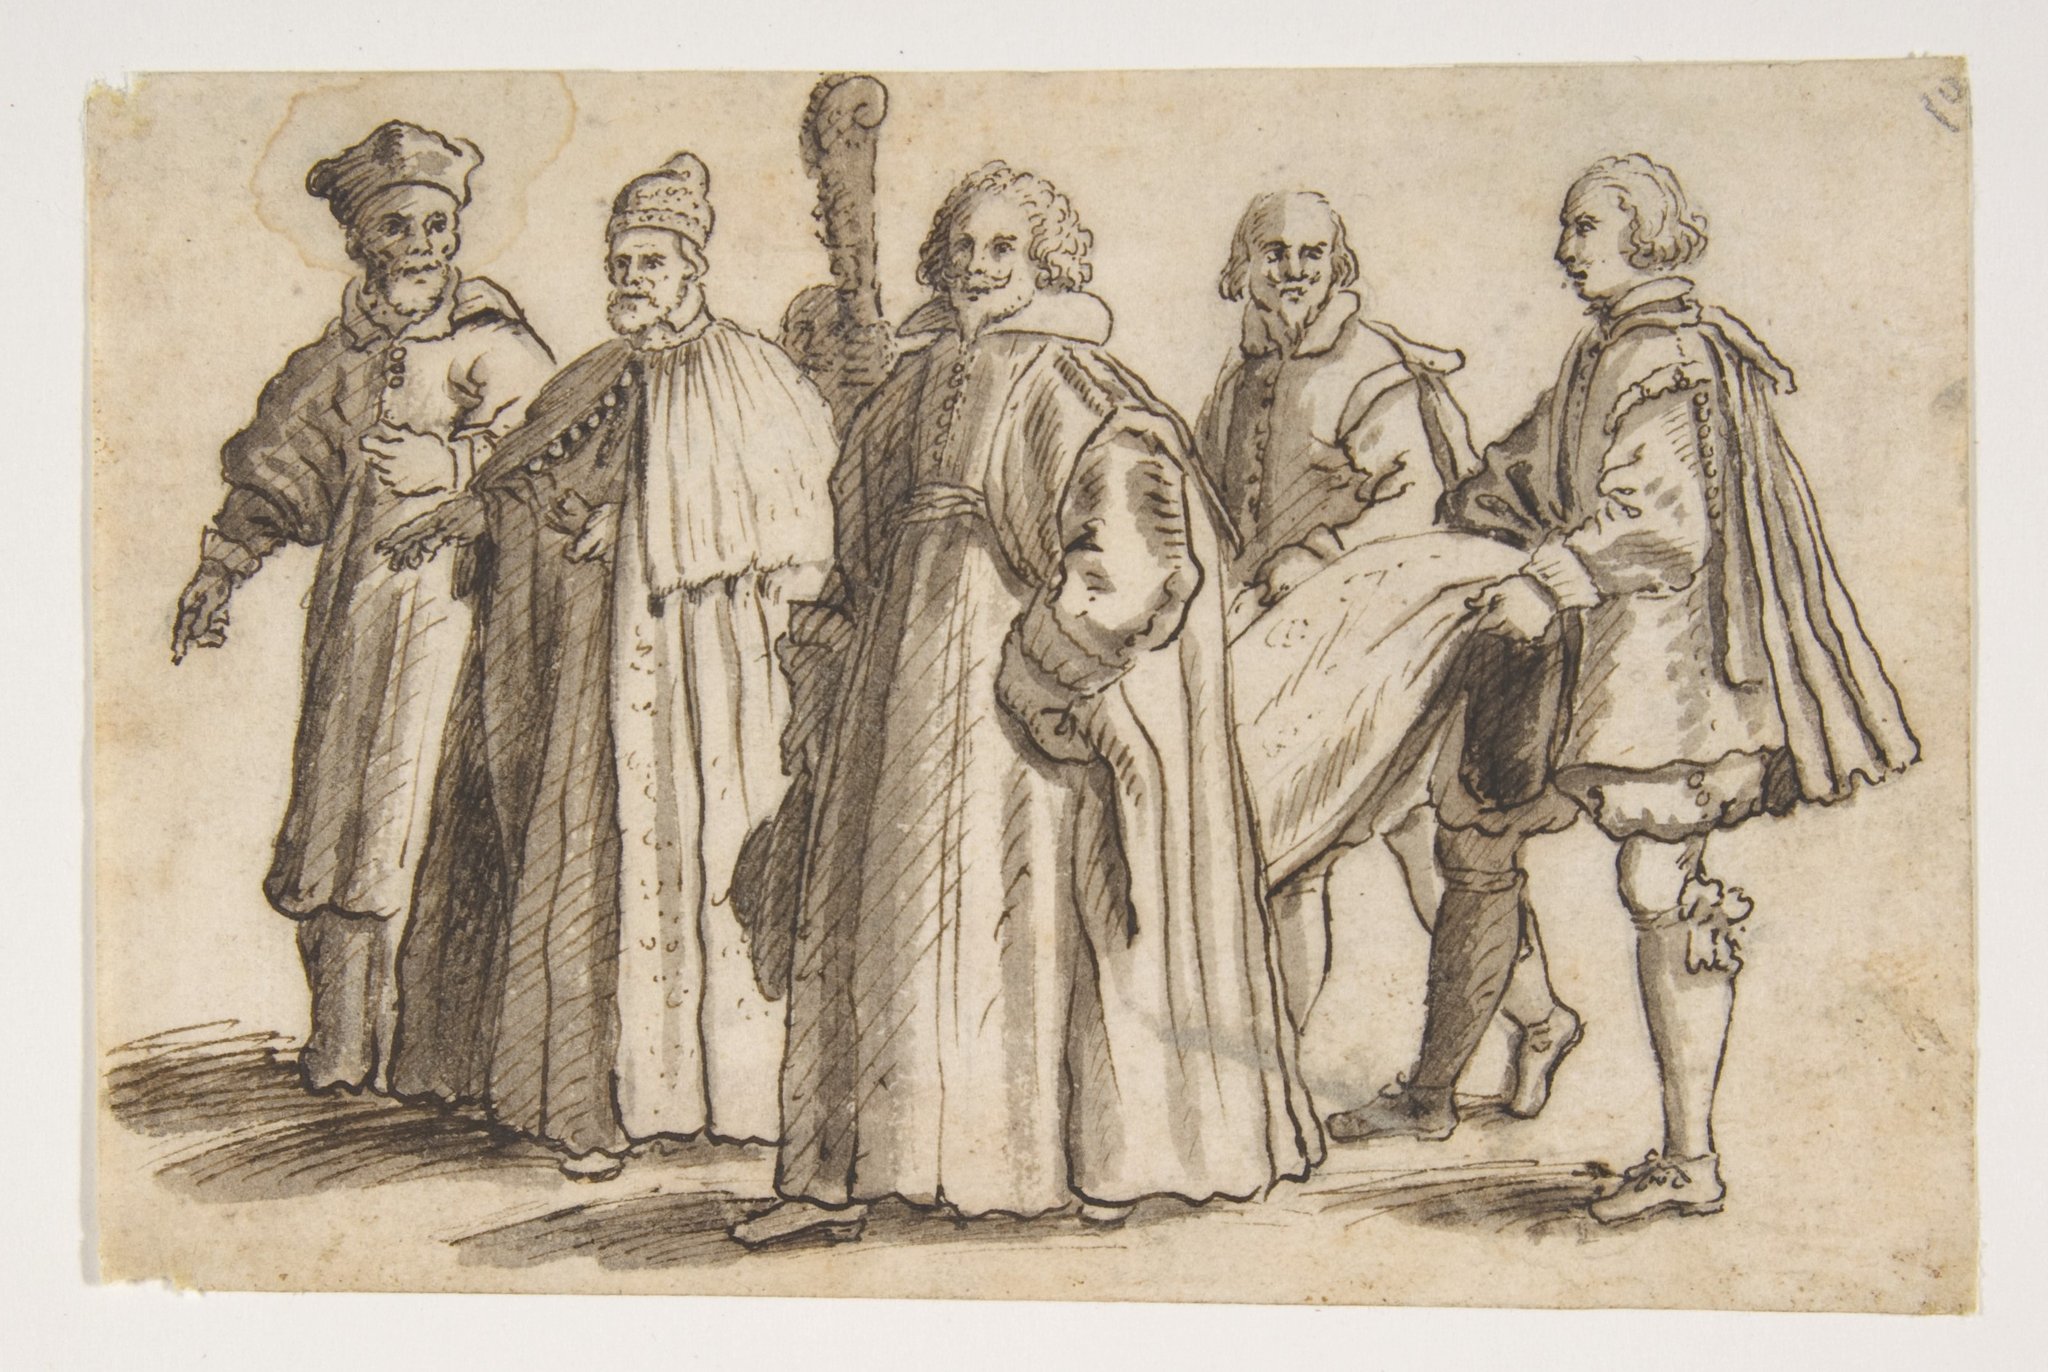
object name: drawing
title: A Doge of Venice with a Cardinal, a Councillor and Servants Bearing the Train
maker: bernardino rodriguez ("bernardino siciliano")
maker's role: artist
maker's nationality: italian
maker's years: 1600-1650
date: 1600-1650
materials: ink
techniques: brush, pen, wash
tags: men